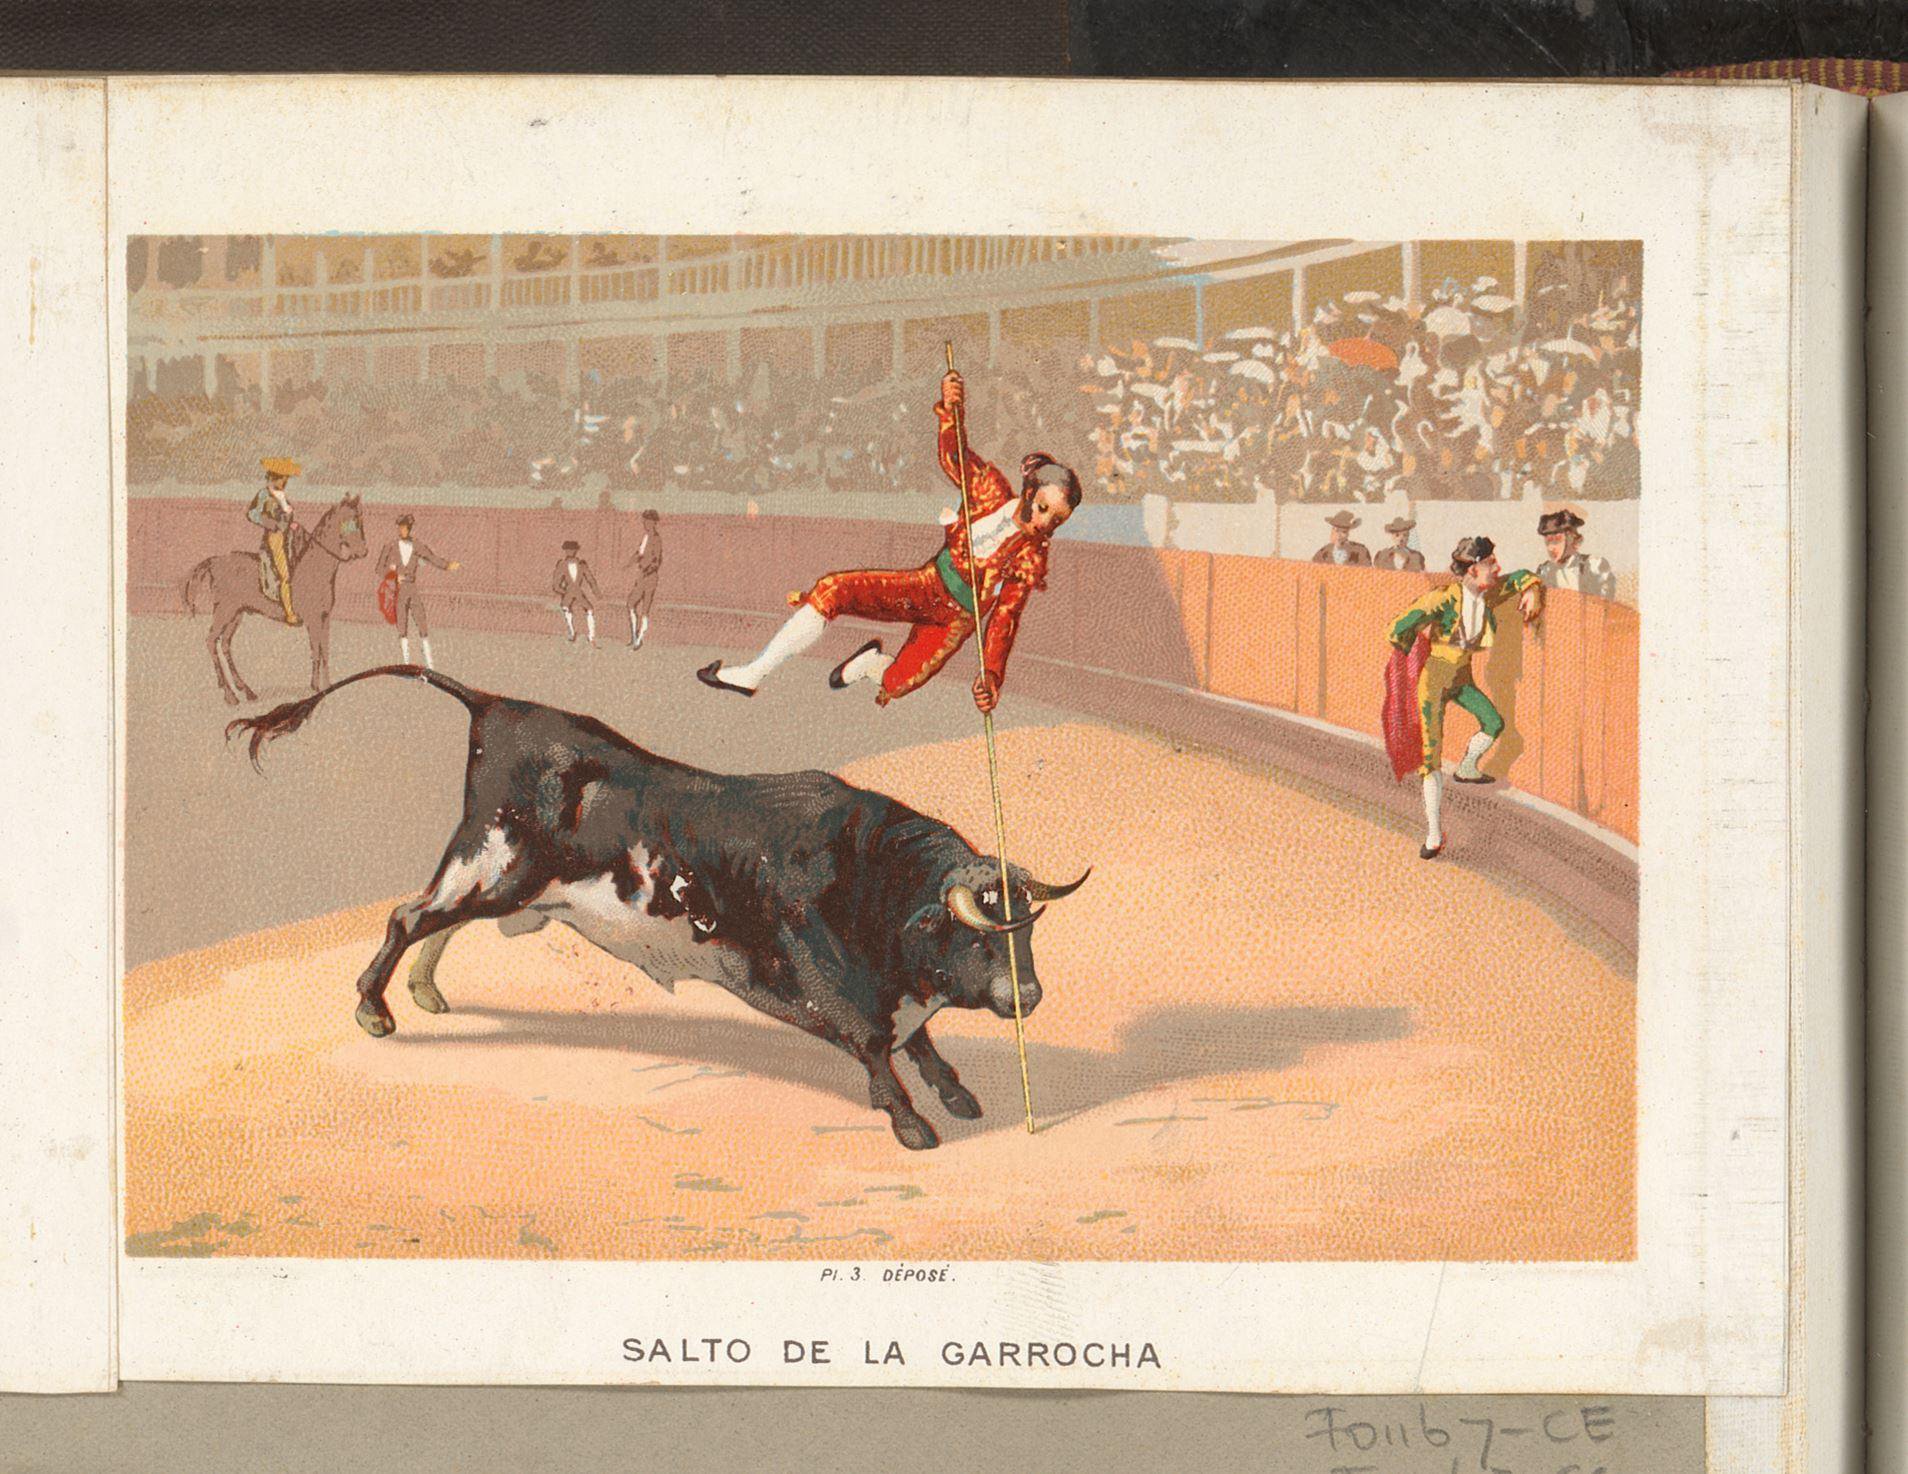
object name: print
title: Salto de la garrocha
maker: Anonymous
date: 1880-1910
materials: paper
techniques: chromolithography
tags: bull-fighter, toreador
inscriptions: inscription: ‘Pl. 3. Déposé’